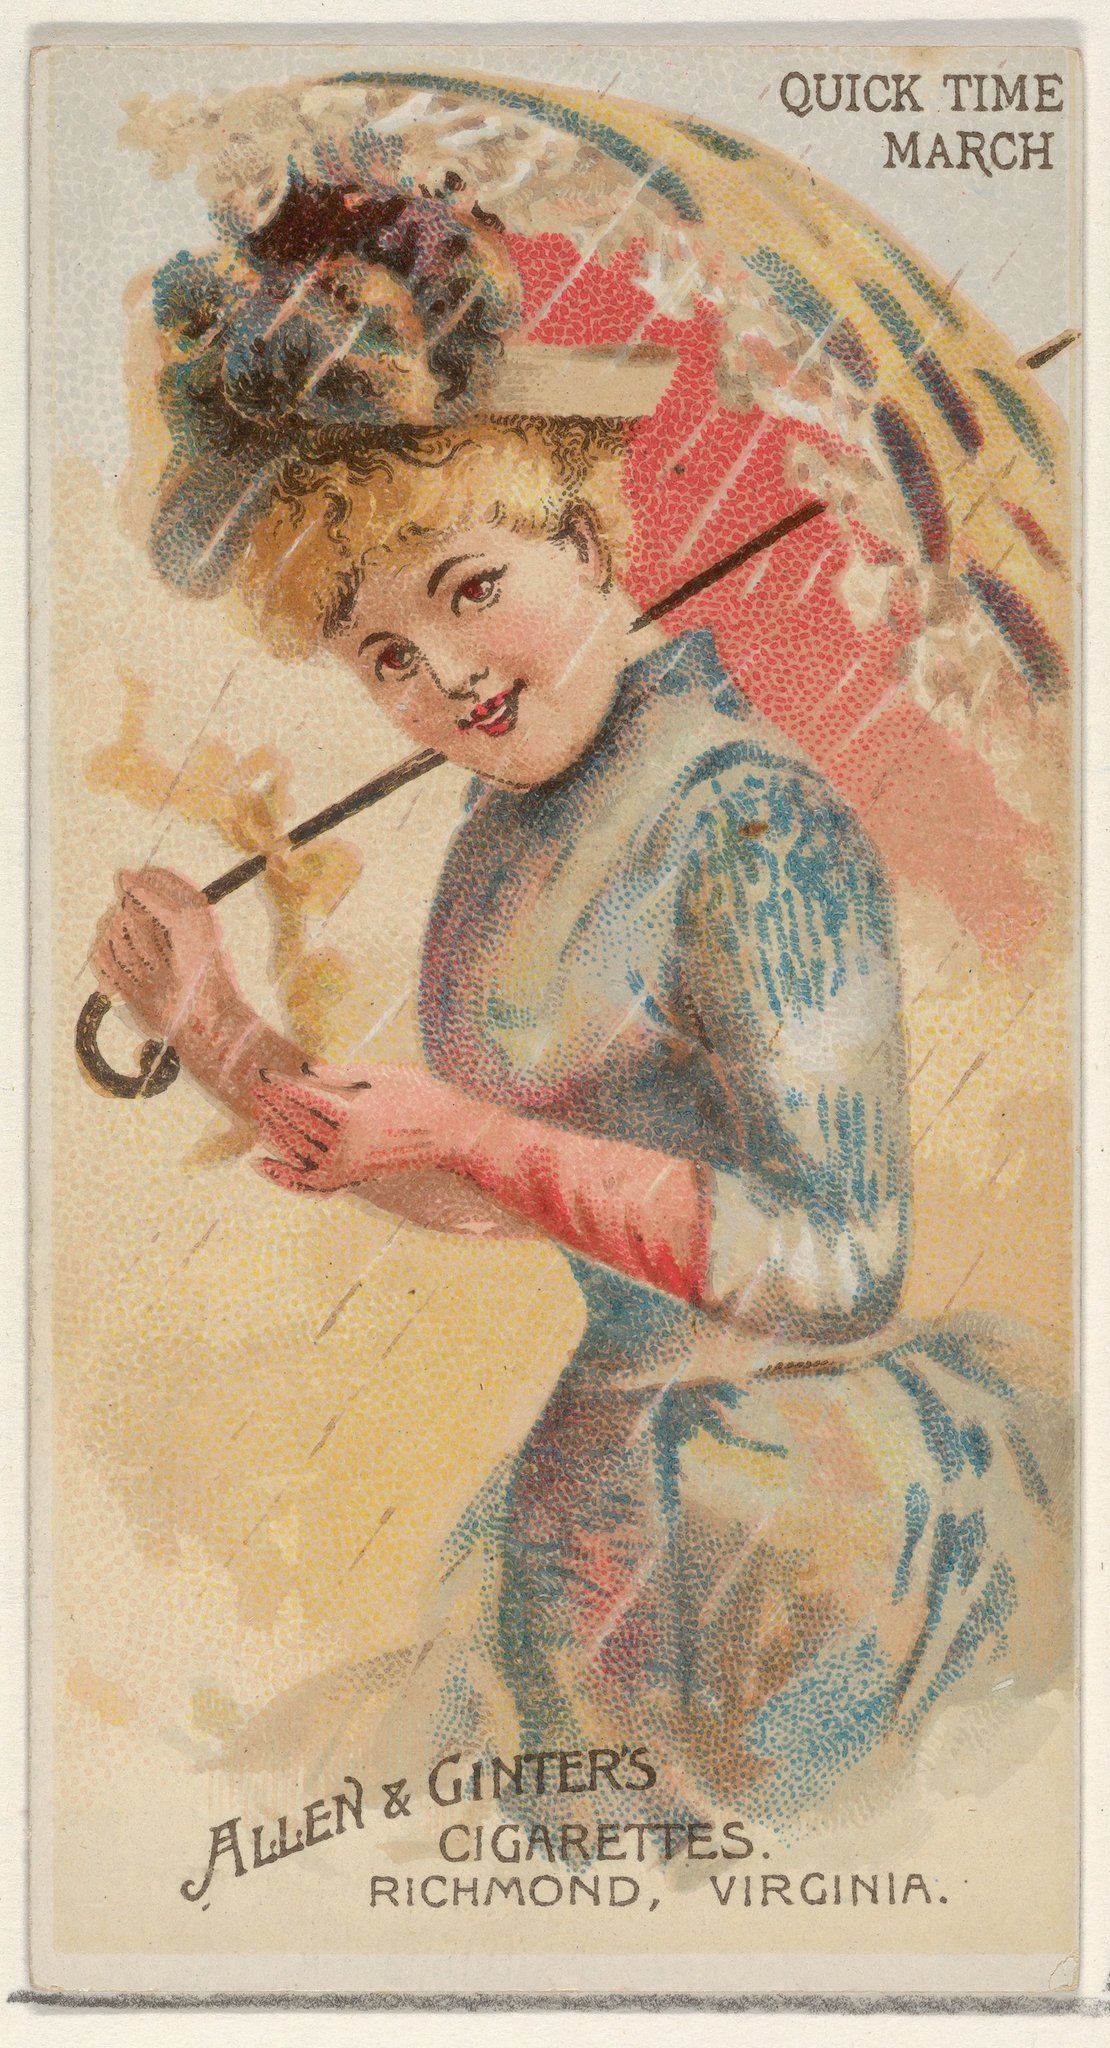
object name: print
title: Quick Time March, from the Parasol Drills series (N18) for Allen & Ginter Cigarettes Brands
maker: allen & ginter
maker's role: publisher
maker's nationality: american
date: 1888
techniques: color lithograph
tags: women